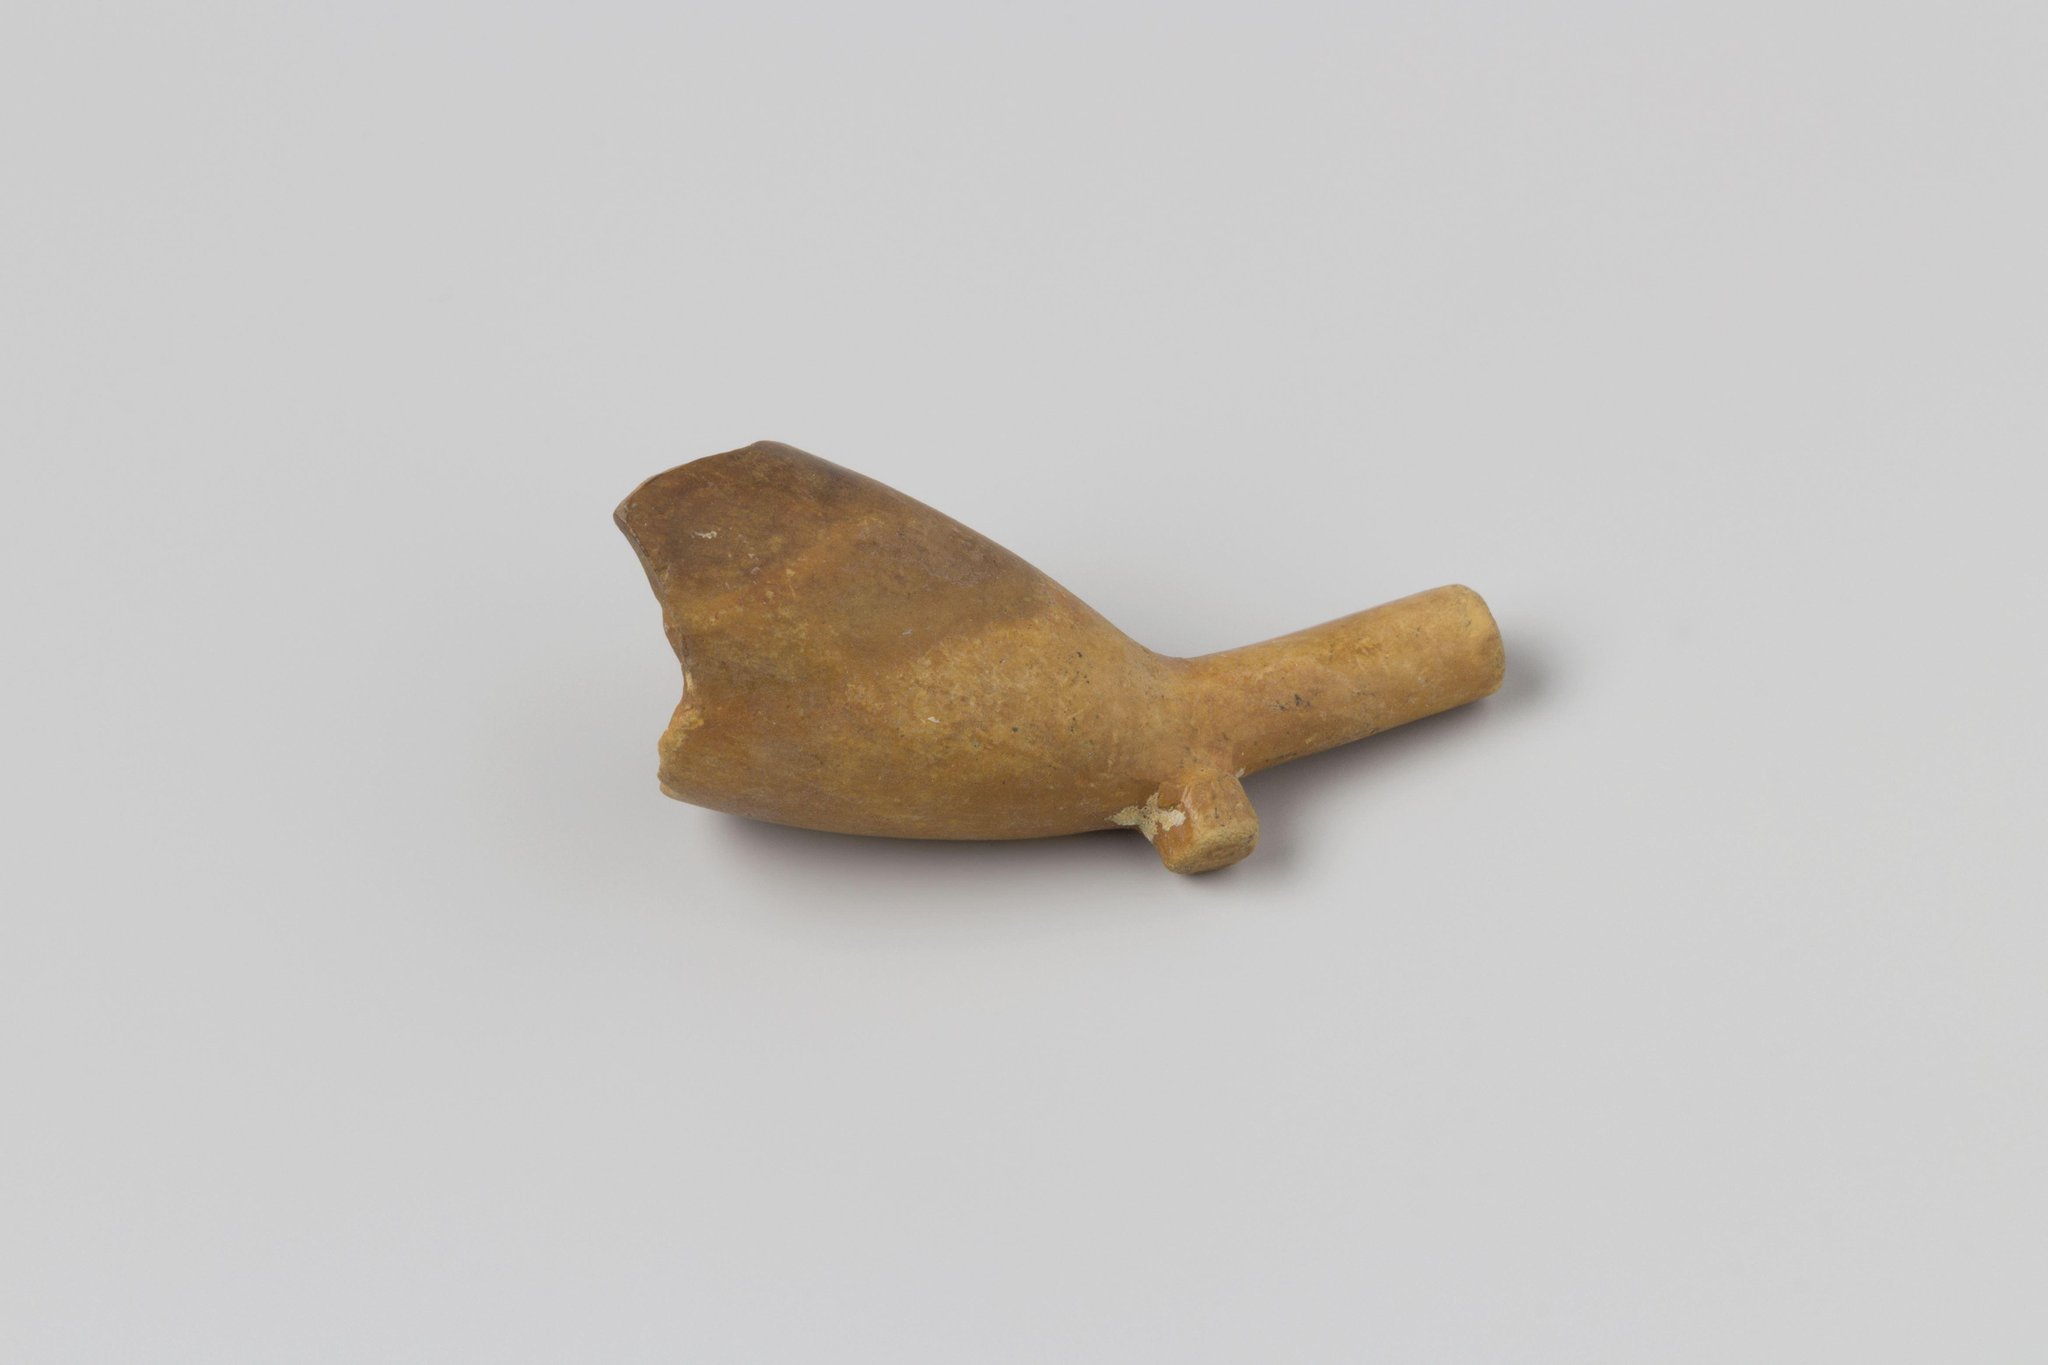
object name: pipe bowl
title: Fragment pijpenkop uit het wrak van de Oost-Indiëvaarder Hollandia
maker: Anonymous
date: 1700-1743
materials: clay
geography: netherlands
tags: verenigde oostindische compagnie, hollandia (schip), annet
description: Pipe, bowl, heelmark: bundle of seven arrows (coat of arms of the seven United Provinces of the Netherlands); fragm, 1hsm1.